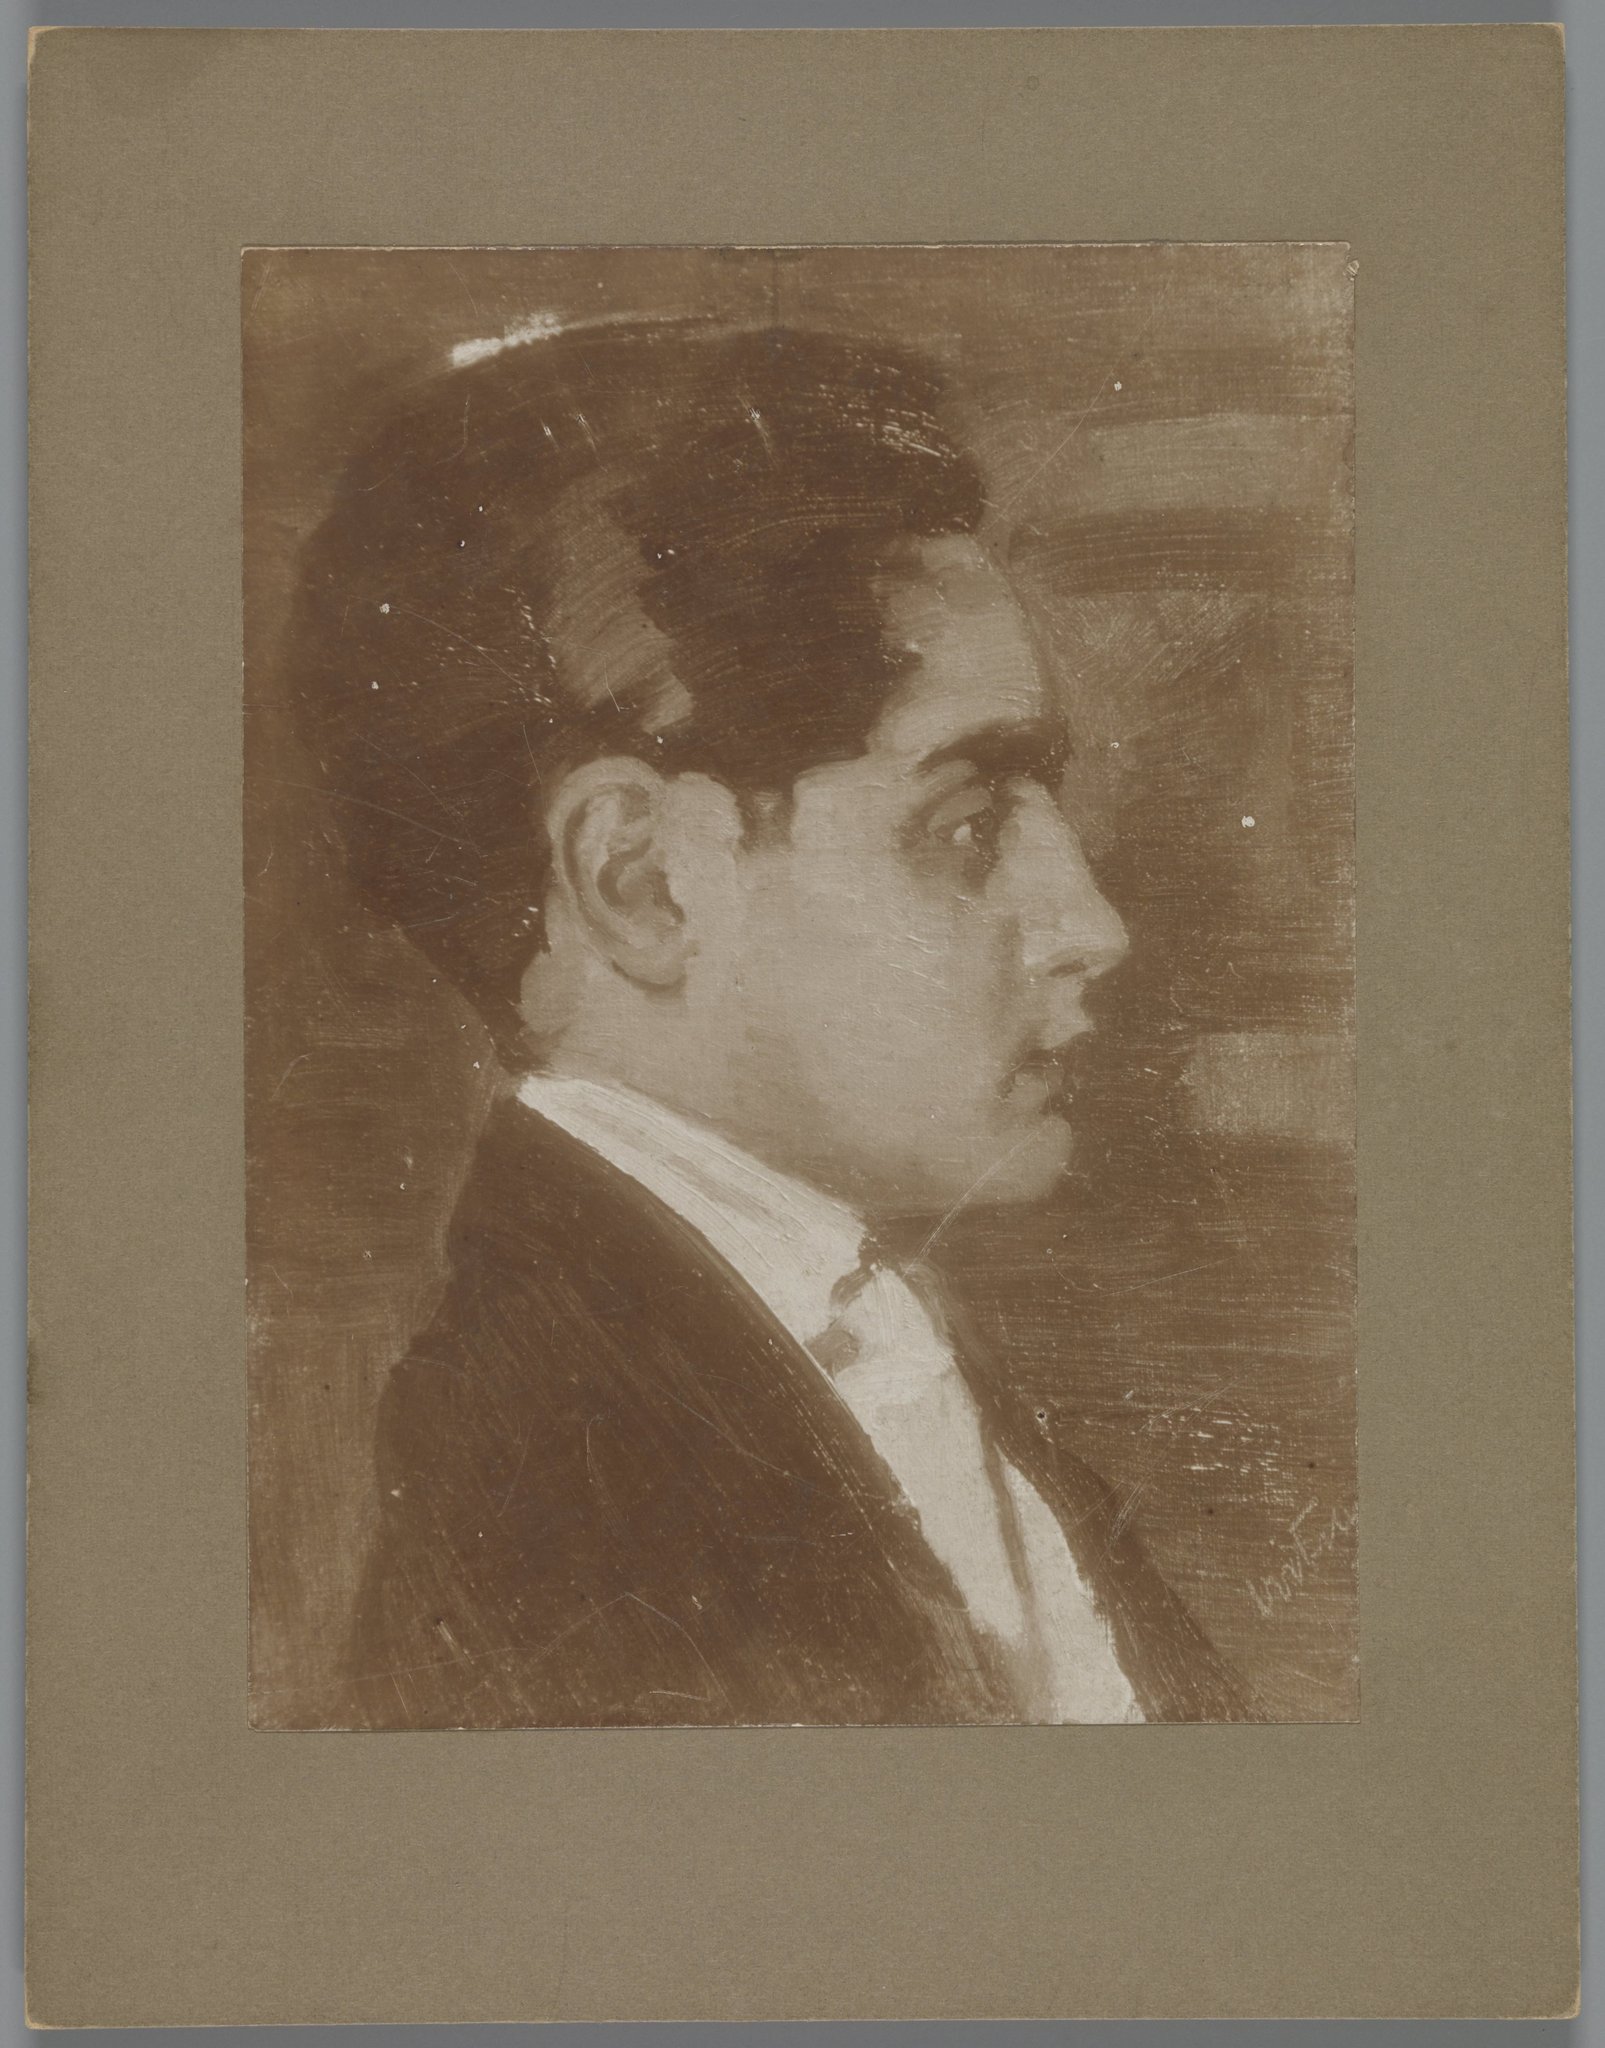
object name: photograph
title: Reproductie naar een foto, schilderij, tekening of prent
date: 1860-1915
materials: cardboard, paper, photographic support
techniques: gelatin silver print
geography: netherlands